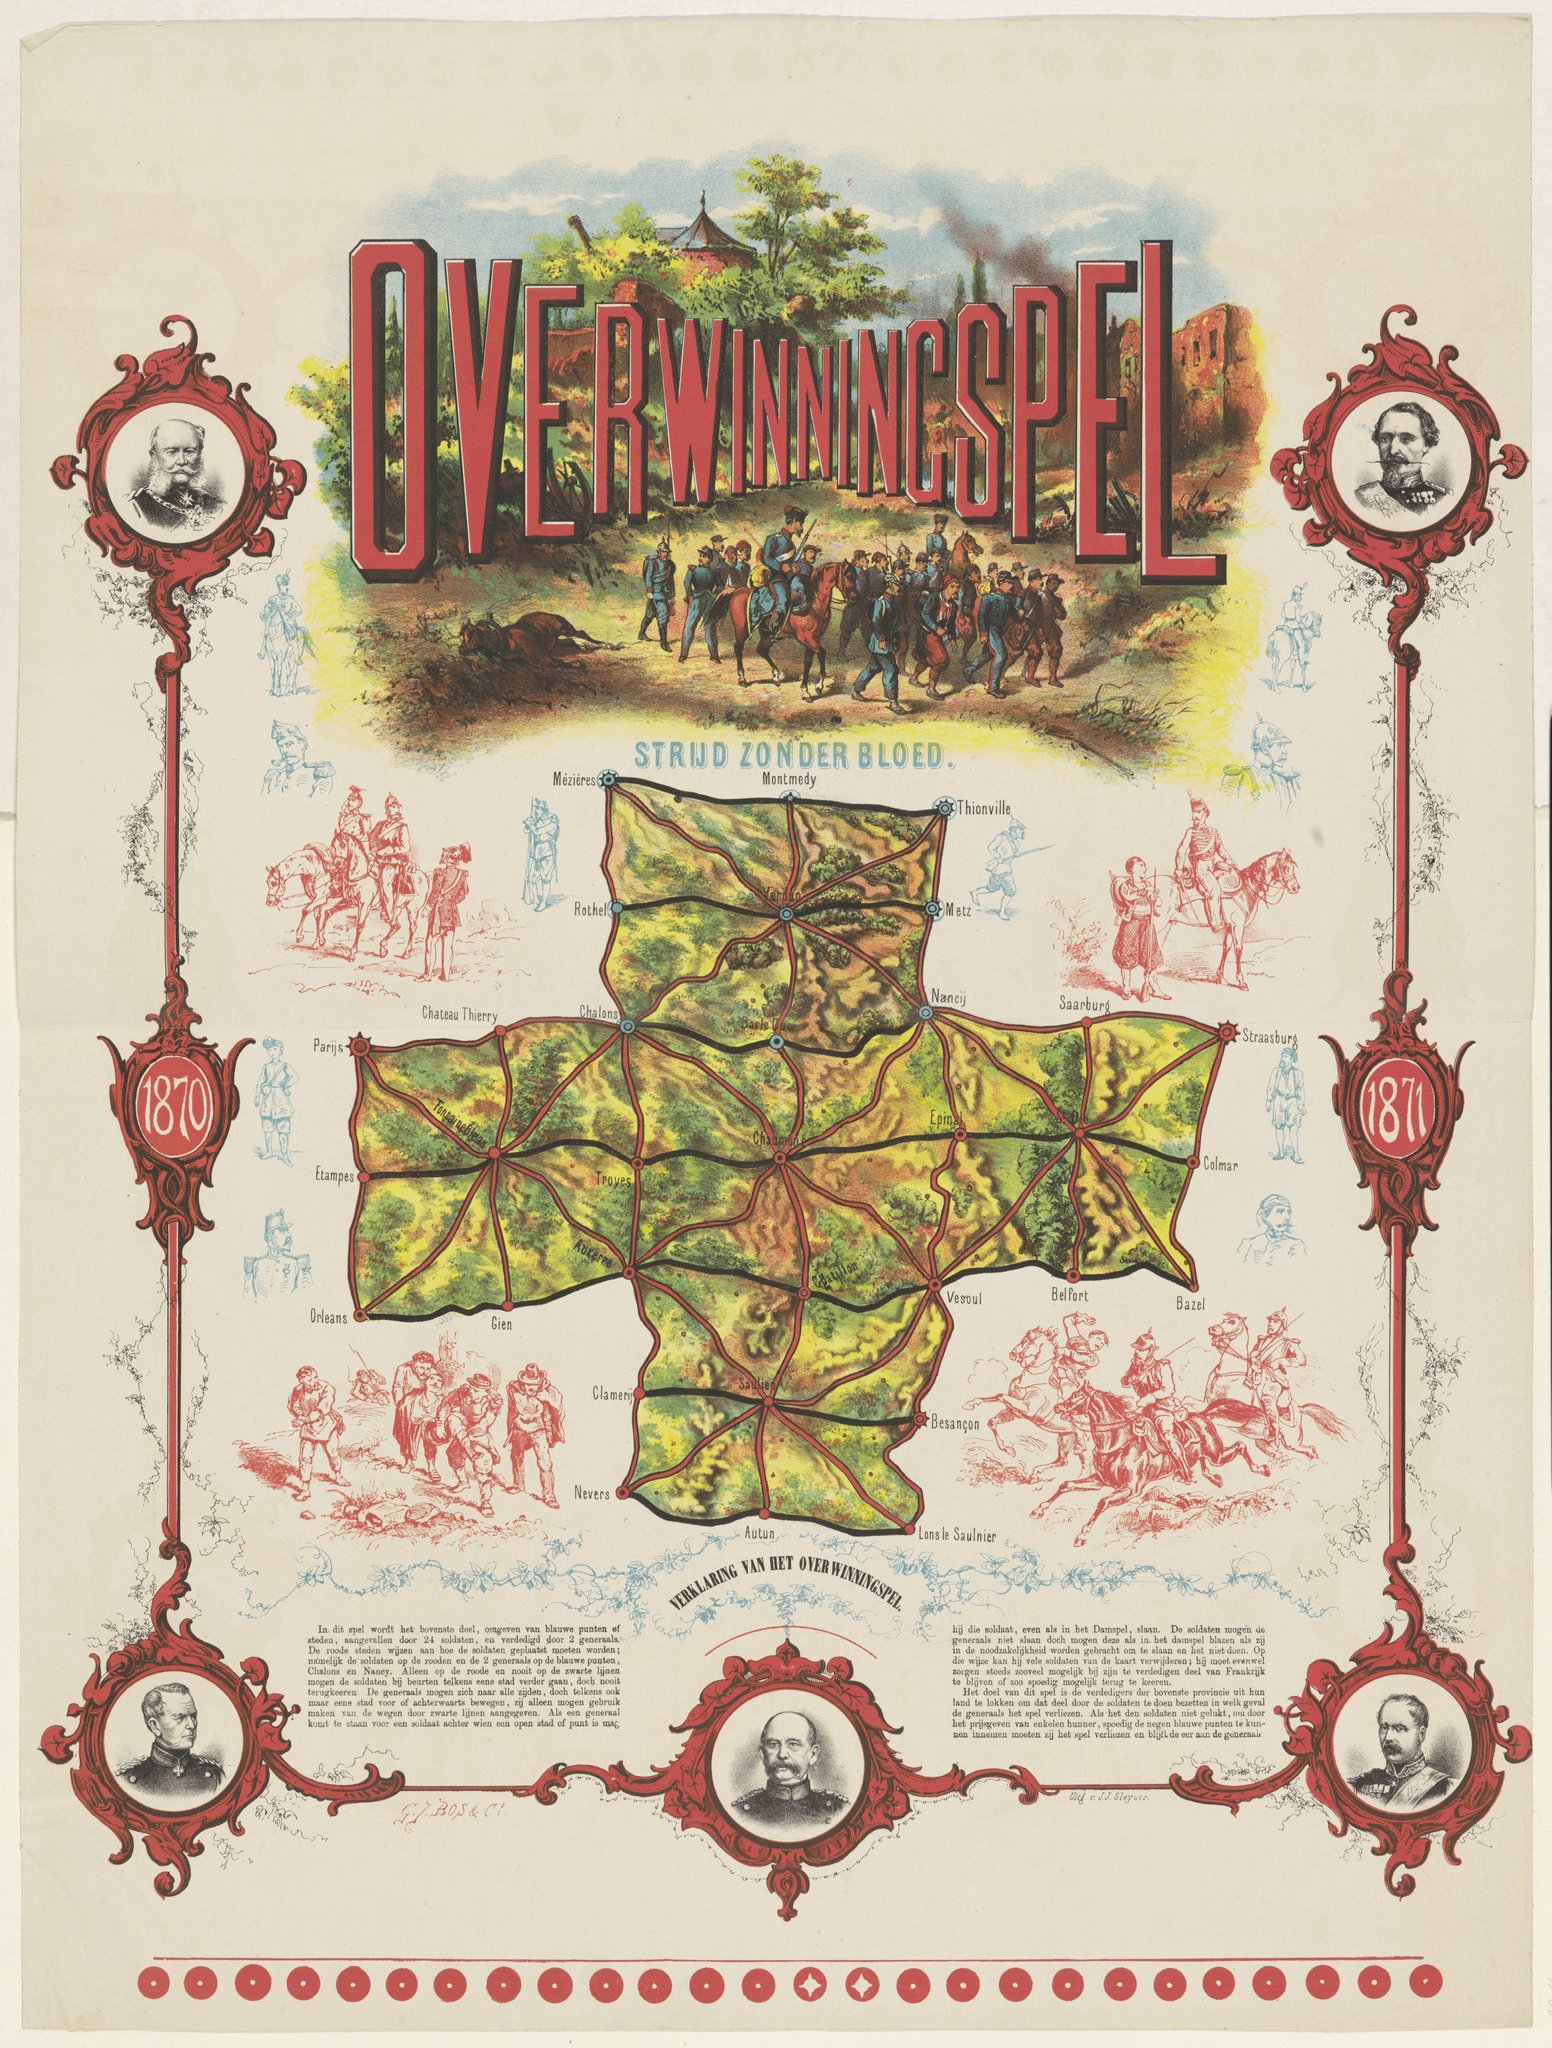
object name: print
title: Overwinningspel / strijd zonder bloed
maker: j.j. sleijser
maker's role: publisher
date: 1871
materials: paper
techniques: lithograph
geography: leiden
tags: board-games of chance, war, board-games, france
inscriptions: collector's mark: Lugt 2760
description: Bordspel over de Frans- Duitse oorlog (1870-1871), Met midden boven groot de titel met een afbeelding van soldaten en gevangenen. Centraal een netwerk van plaatsnamen met stippen. Rondom het speelveld afbeeldingen van soldaten. Links- en rechtsonder de spelregels in twee kolommen. Het geheel is omgeven door een sierlijst met portretten.